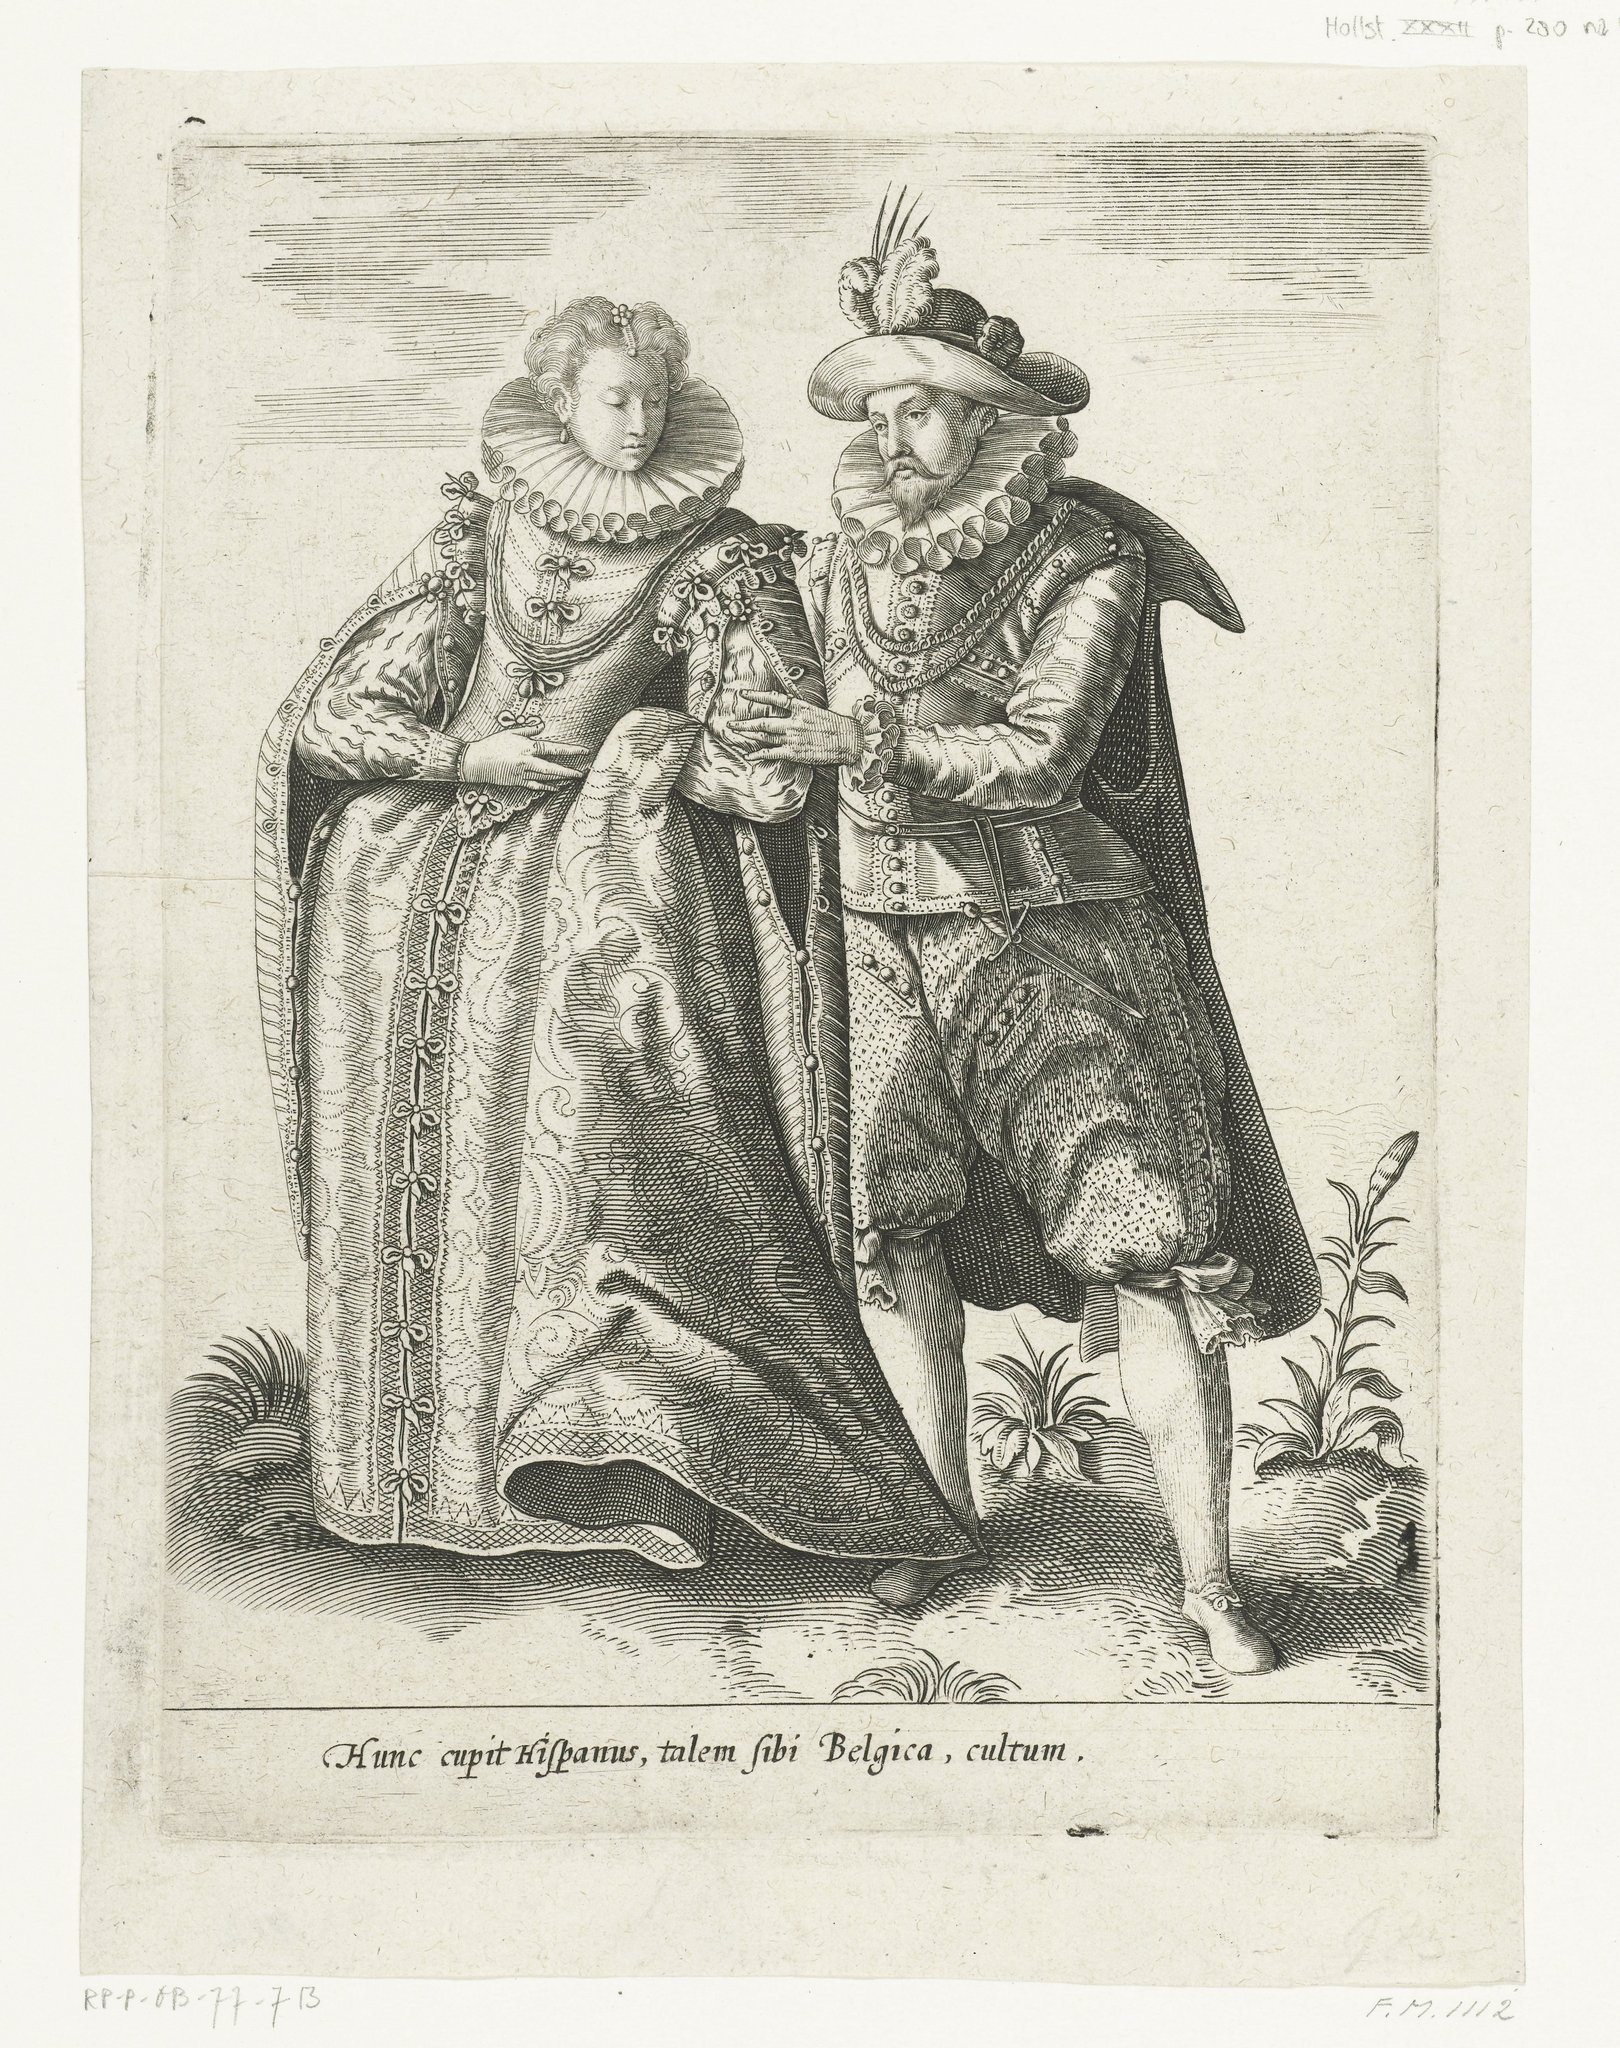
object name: costume print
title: Spaanse man en Vlaamse vrouw in modieuze kleding ca. 1600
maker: Anonymous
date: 1615-1625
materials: paper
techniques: engraving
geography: low countries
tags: bow (ornamental part of clothing) (+ women's clothes), neck-gear ~ clothing (with name) (+ men's clothes), europeans: spaniards (+ costume), sleeves, head-gear: hat (+ men's clothes), clothes, costume (+ women's clothes), neck-gear ~ clothing (with name) (+ women's clothes), shoes, sandals (+ men's clothes), clothes, costume (+ men's clothes), trousers, breeches, etc. (breeches) (+ men's clothes), clothing for the upper part of the body (doublet) (+ men's clothes), clothing for the upper part of the body (with name) (+ women's clothes), europeans (with name) (+ costume), low countries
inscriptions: caption: ‘Hunc cupit Hispanus, talem sibi Belgica, cultum’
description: Staande man en vrouw in modieuze kleding van de zuidelijke Nederlanden, ca. 1600. De heer biedt een rijk geklede dame de arm. Beiden dragen de stijf geplooide Spaanse kraag. Met onderschrift Hunc cupit Hispanus, talem sibi Belgica, cultum, waarvan de vertaling luidt: "deze opsmuk begeert zowel de Spaanse man als de Zuidnederlandse vrouw voor zichzelve."